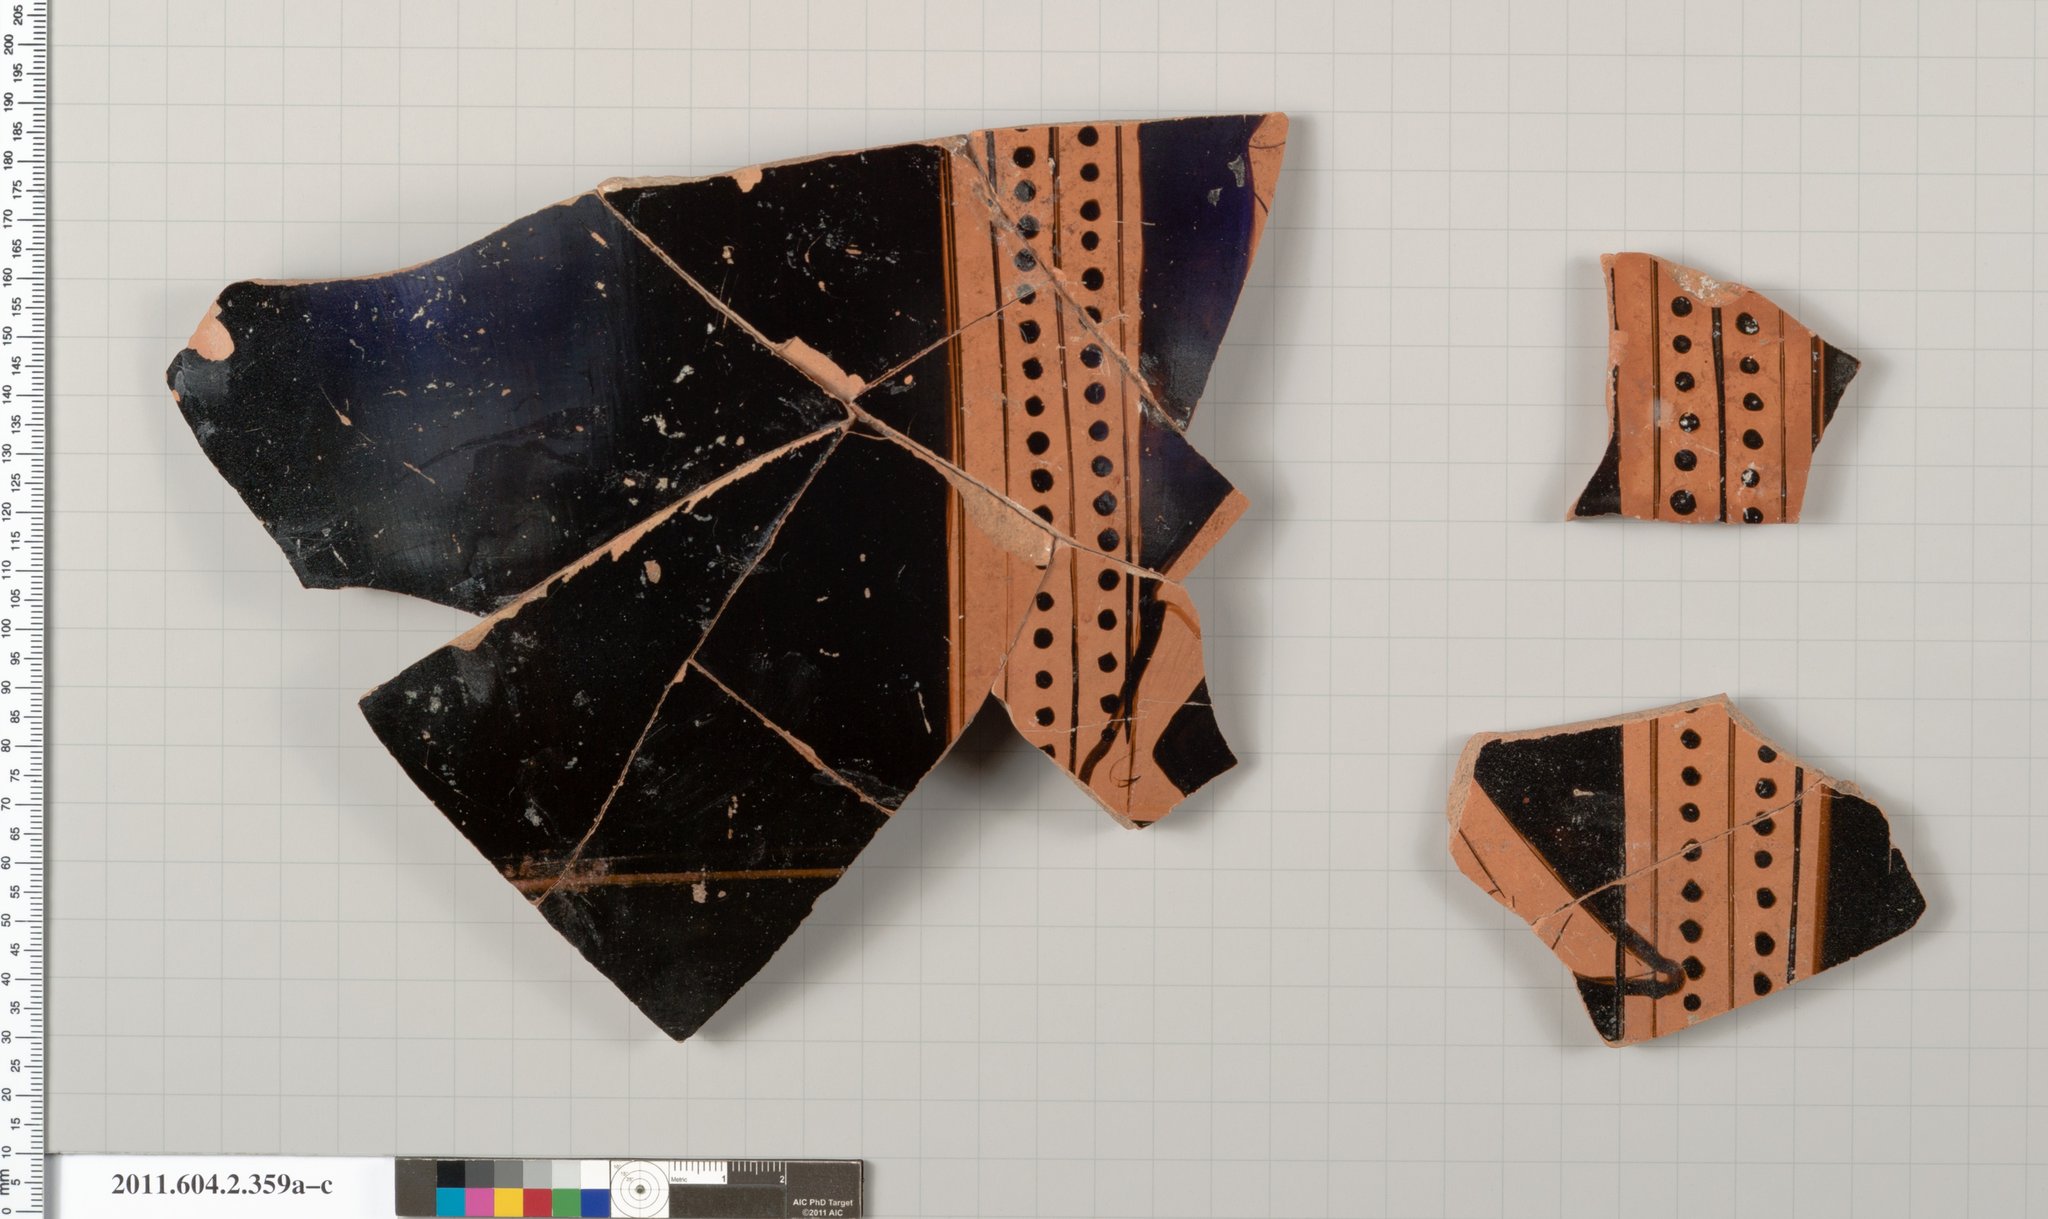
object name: column krater fragment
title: Terracotta fragments of a column-krater (bowl for mixing wine and water)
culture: greek, attic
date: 430-420 BCE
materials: terracotta